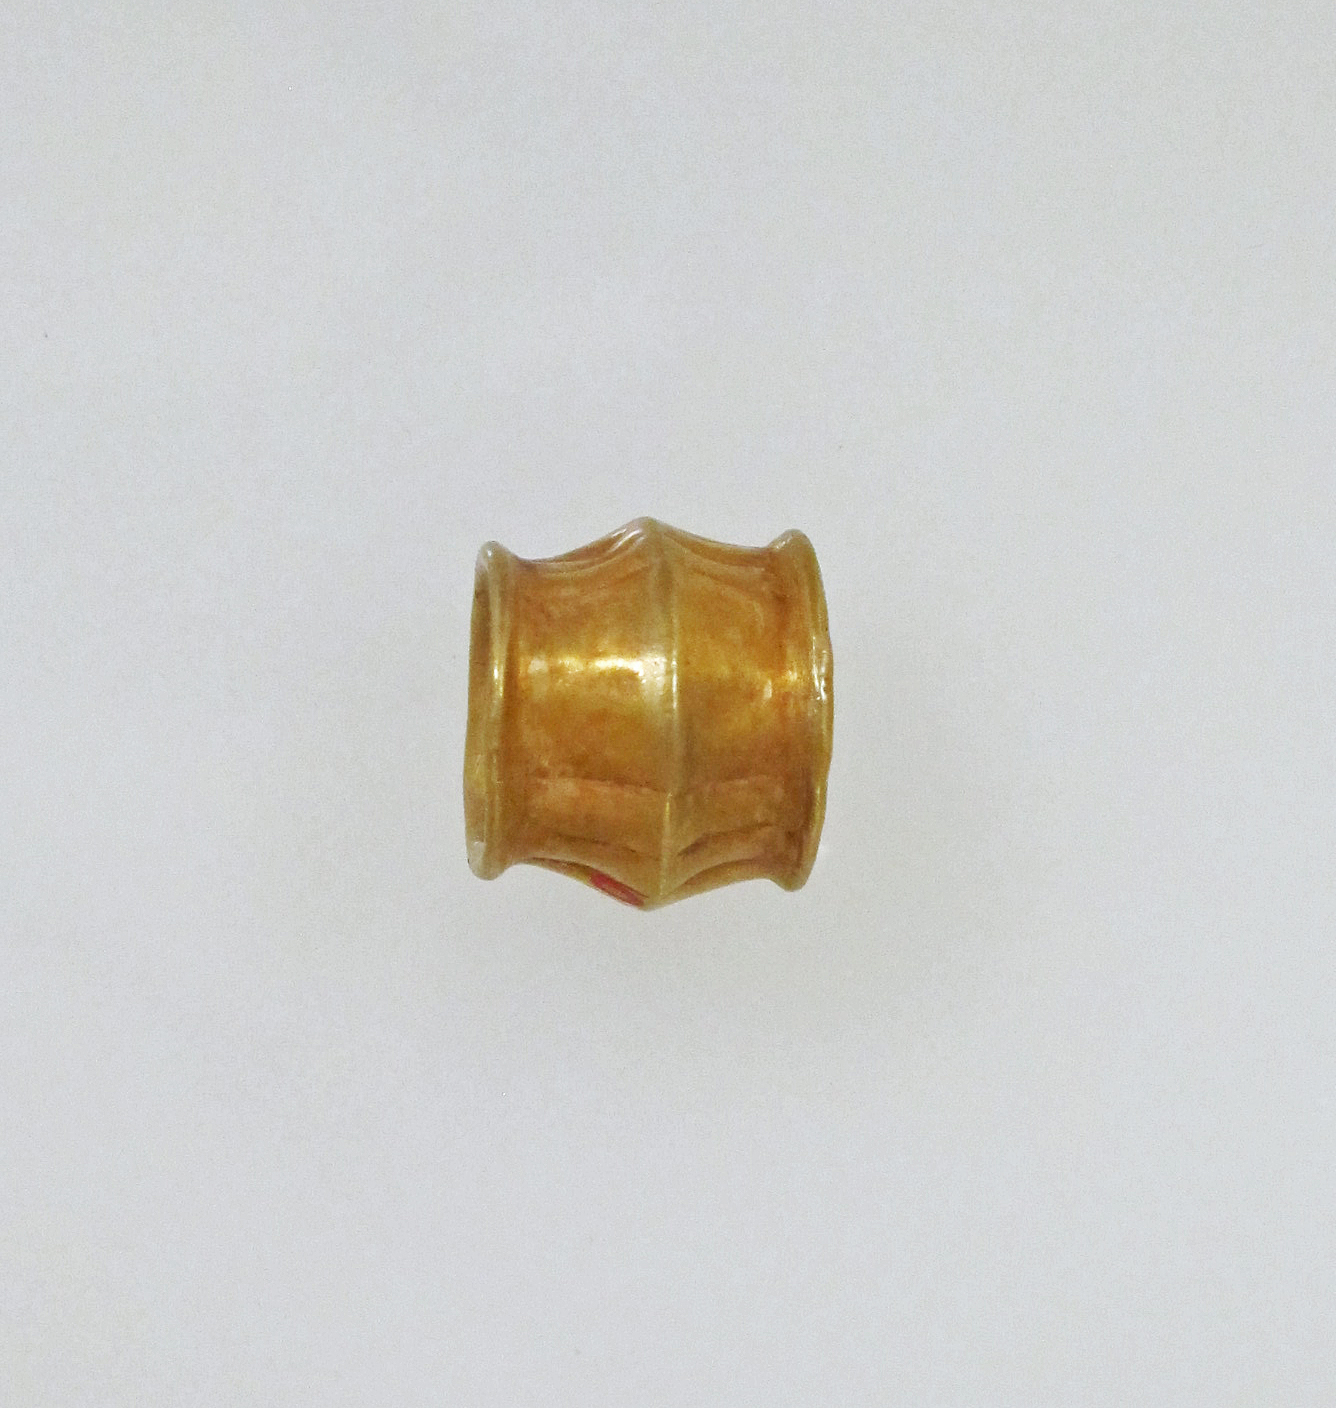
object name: bead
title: Gold bead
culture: minoan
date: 2300-2100 BCE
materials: gold